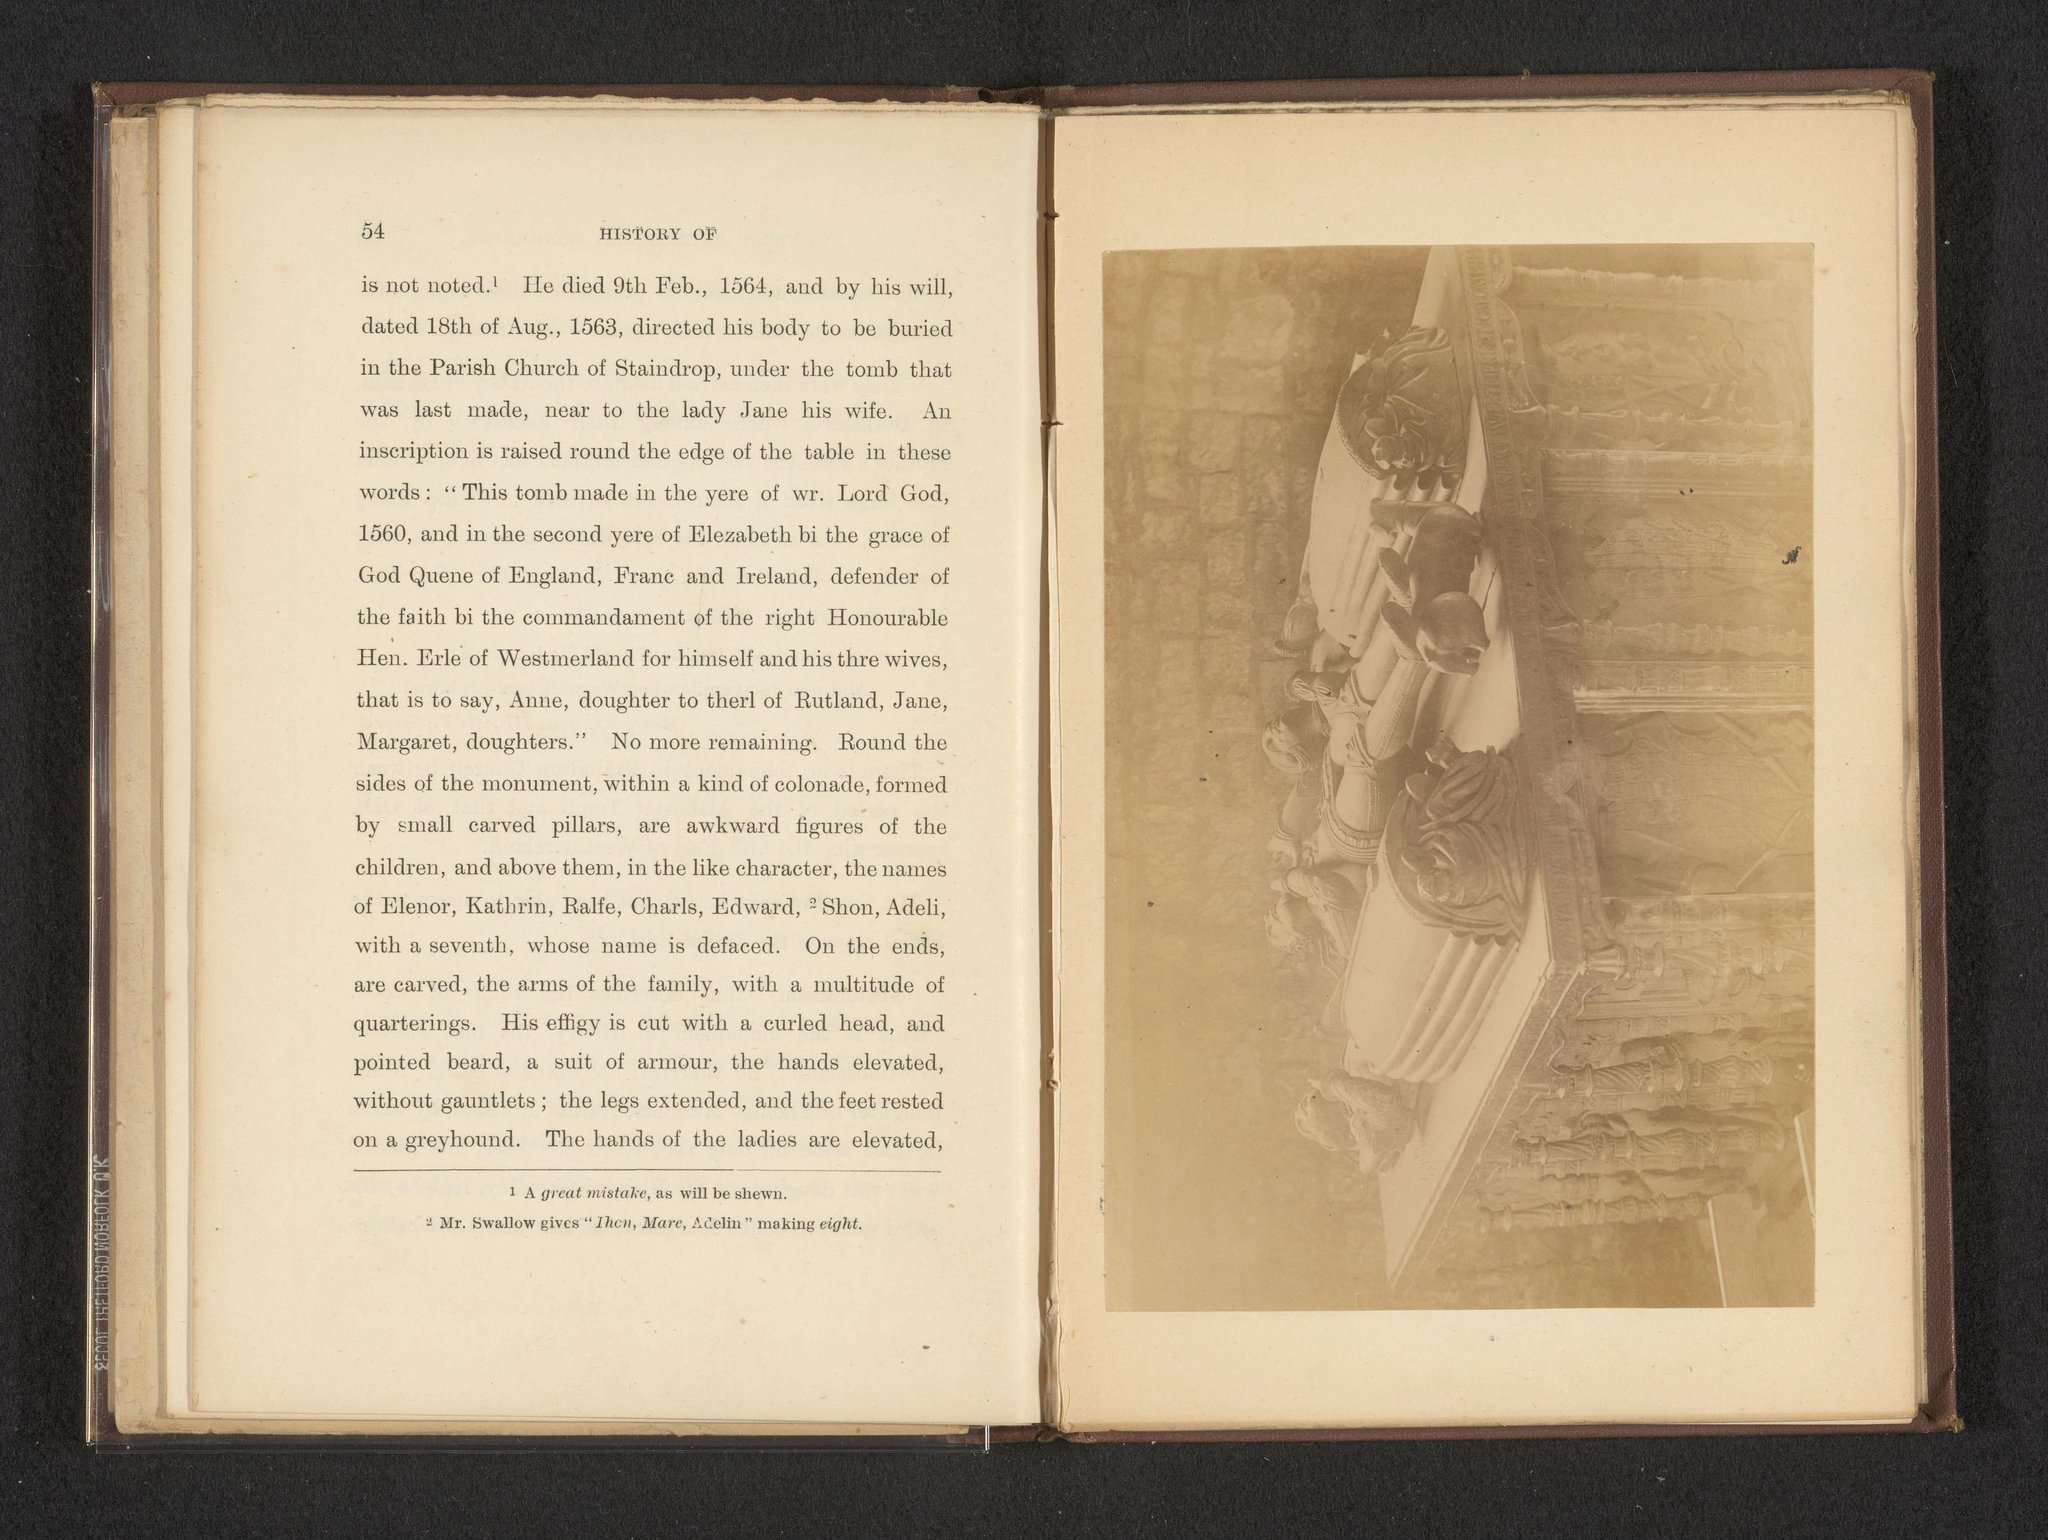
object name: photograph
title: Grafmonument van Henry Neville, Anne Rutland en Jane Chalmondeley in Saint Mary's Church te Staindrop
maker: Anonymous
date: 1878-1888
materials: photographic support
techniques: albumen print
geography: saint mary's church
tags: effigy, 'gisant' (portrait-figure on closed coffin or in 'castrum doloris'), transi, interior of church, grave-building, monumental tomb